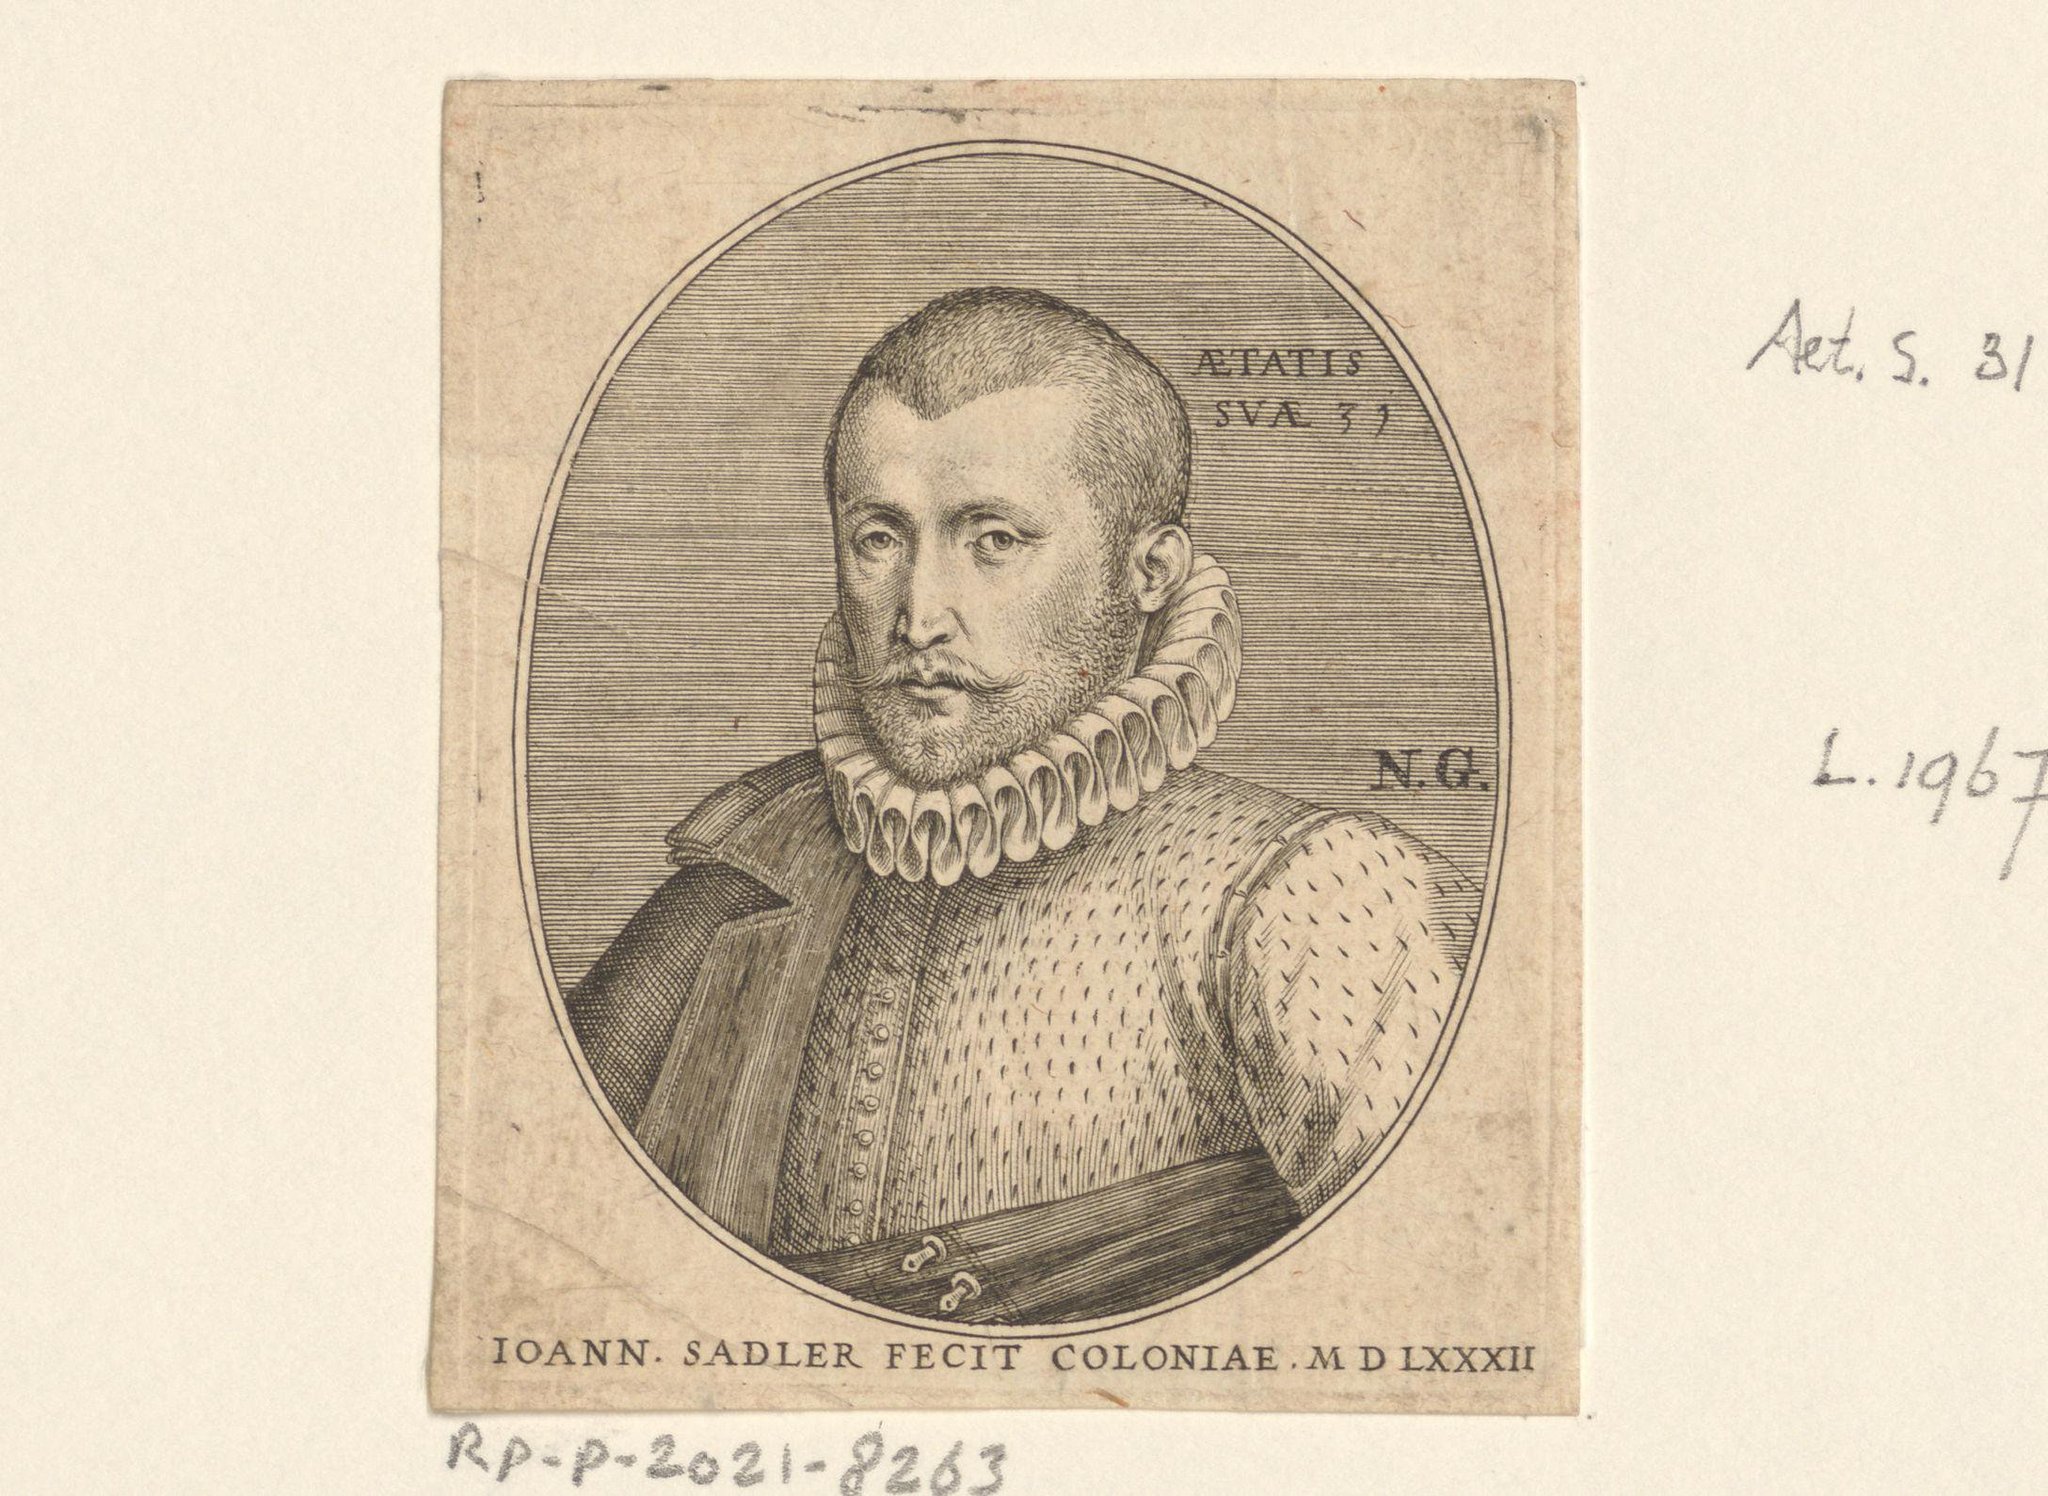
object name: print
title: Zelfportret op 31-jarige leeftijd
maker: johann sadeler (i)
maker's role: print maker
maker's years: 1550-1600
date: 1582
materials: paper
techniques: engraving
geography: cologne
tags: brussels, venice, johann sadeler (i), historical persons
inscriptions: collector's mark: Lugt 2228, collector's mark: Lugt 1967